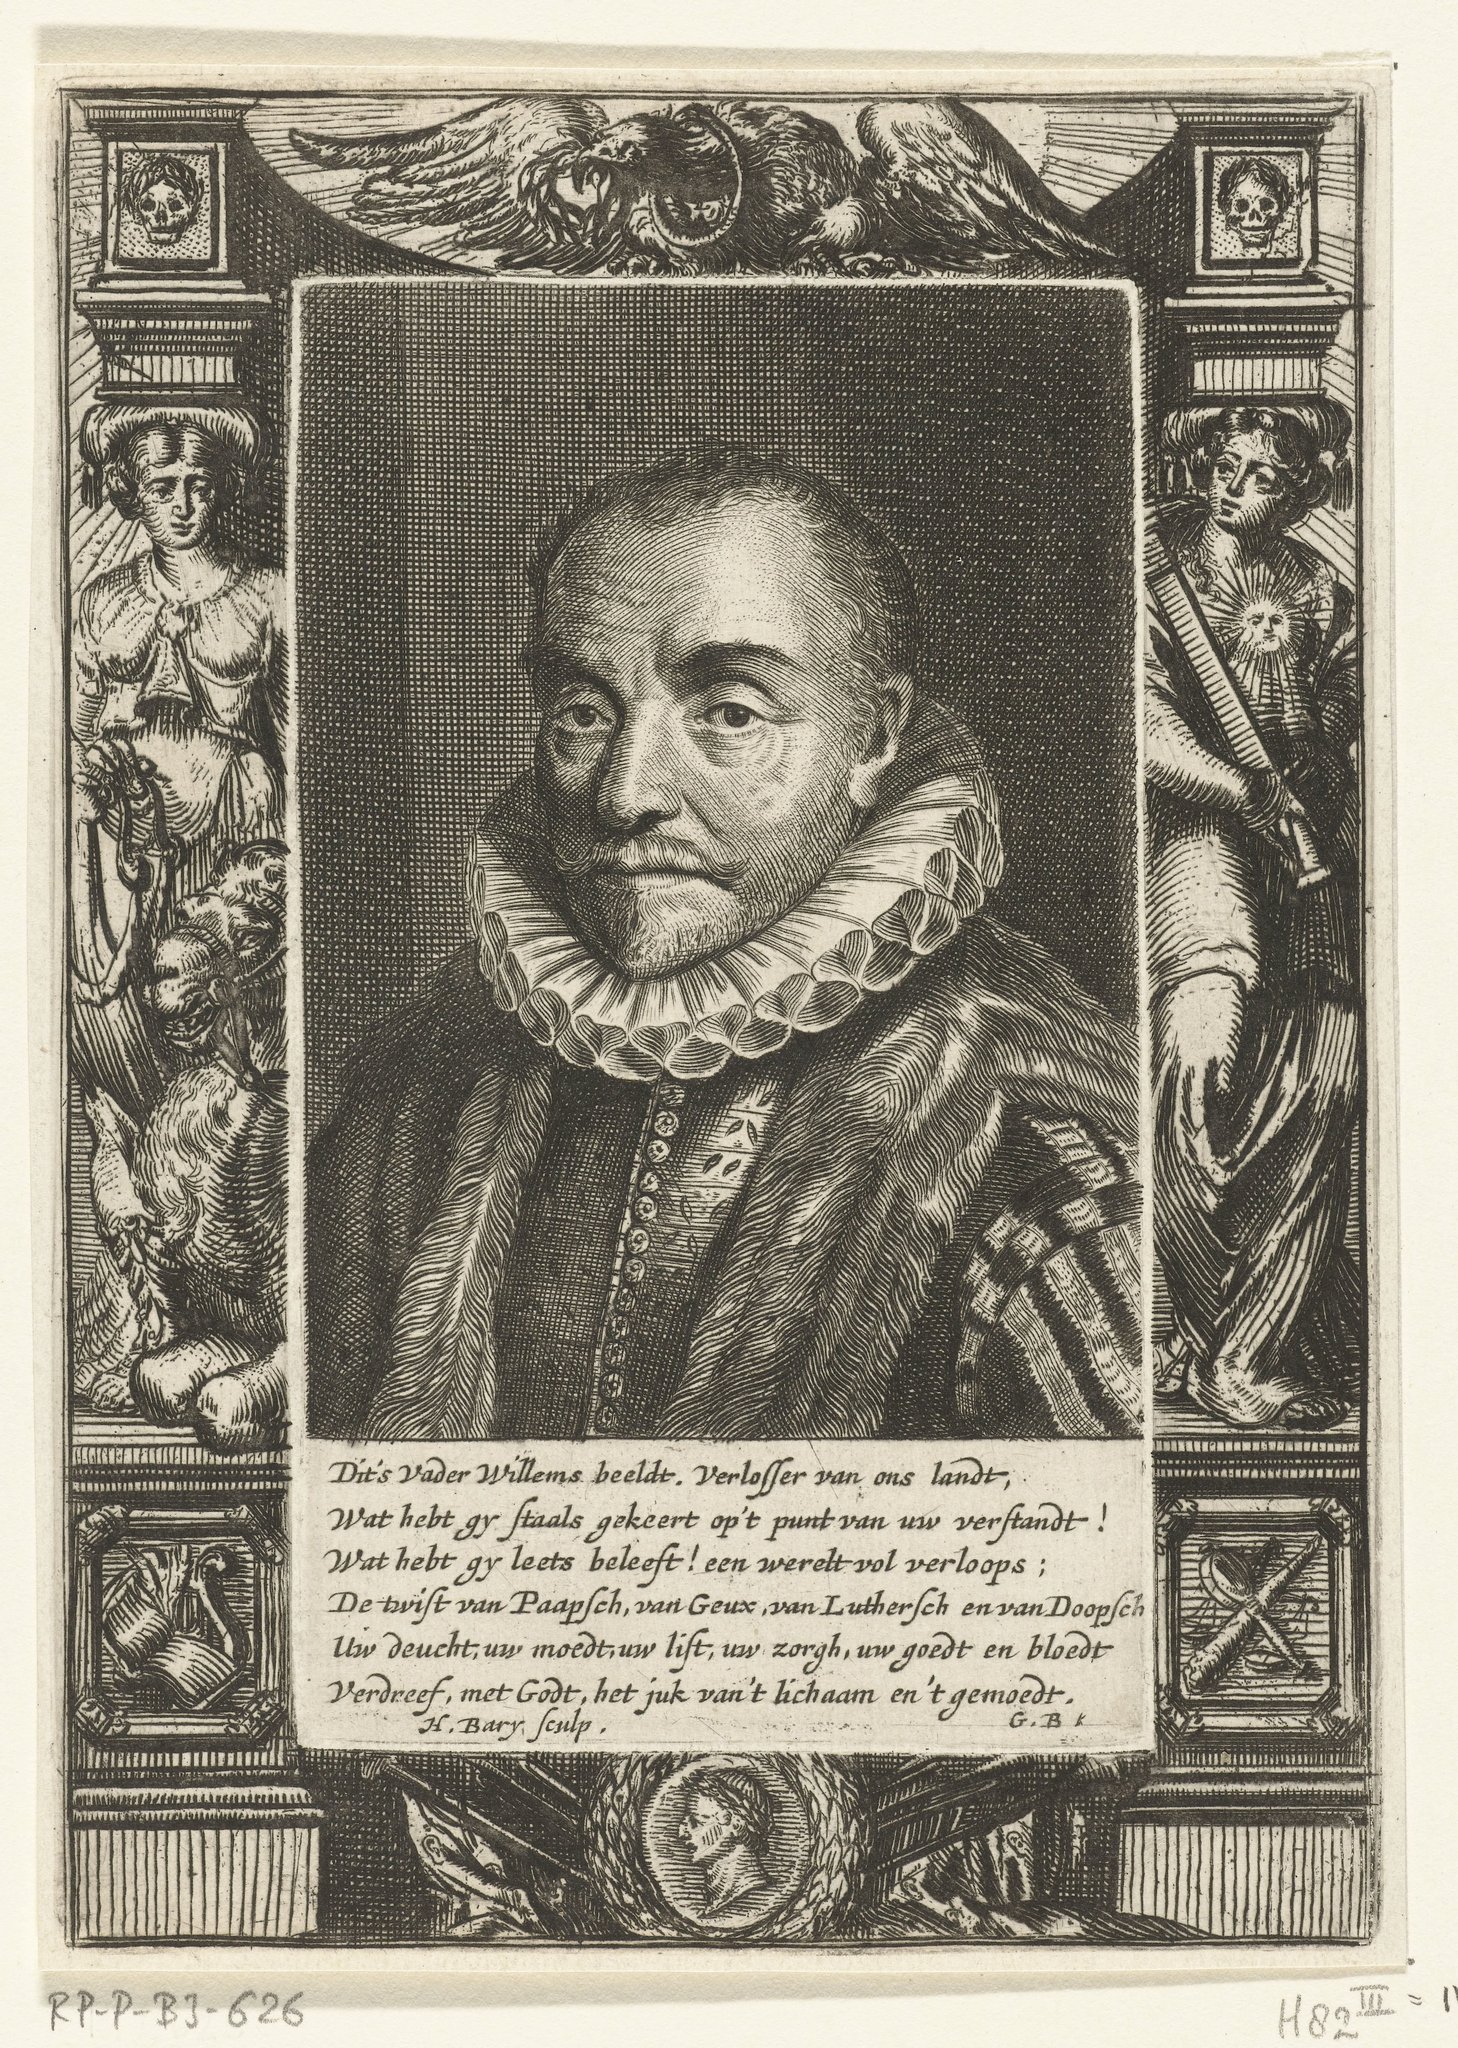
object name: print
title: Portret van Willem I, prins van Oranje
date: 1657-1707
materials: paper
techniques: engraving, etching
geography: netherlands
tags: william i (prince of orange)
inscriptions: collector's mark: Lugt 2228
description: Prent gedrukt van twee platen. Portret van Willem I, prins van Oranje. Onder het portret een vers van zes regels in het Nederlands van G. Brandt. Omlijsting met allegorische figuren en symbolen.